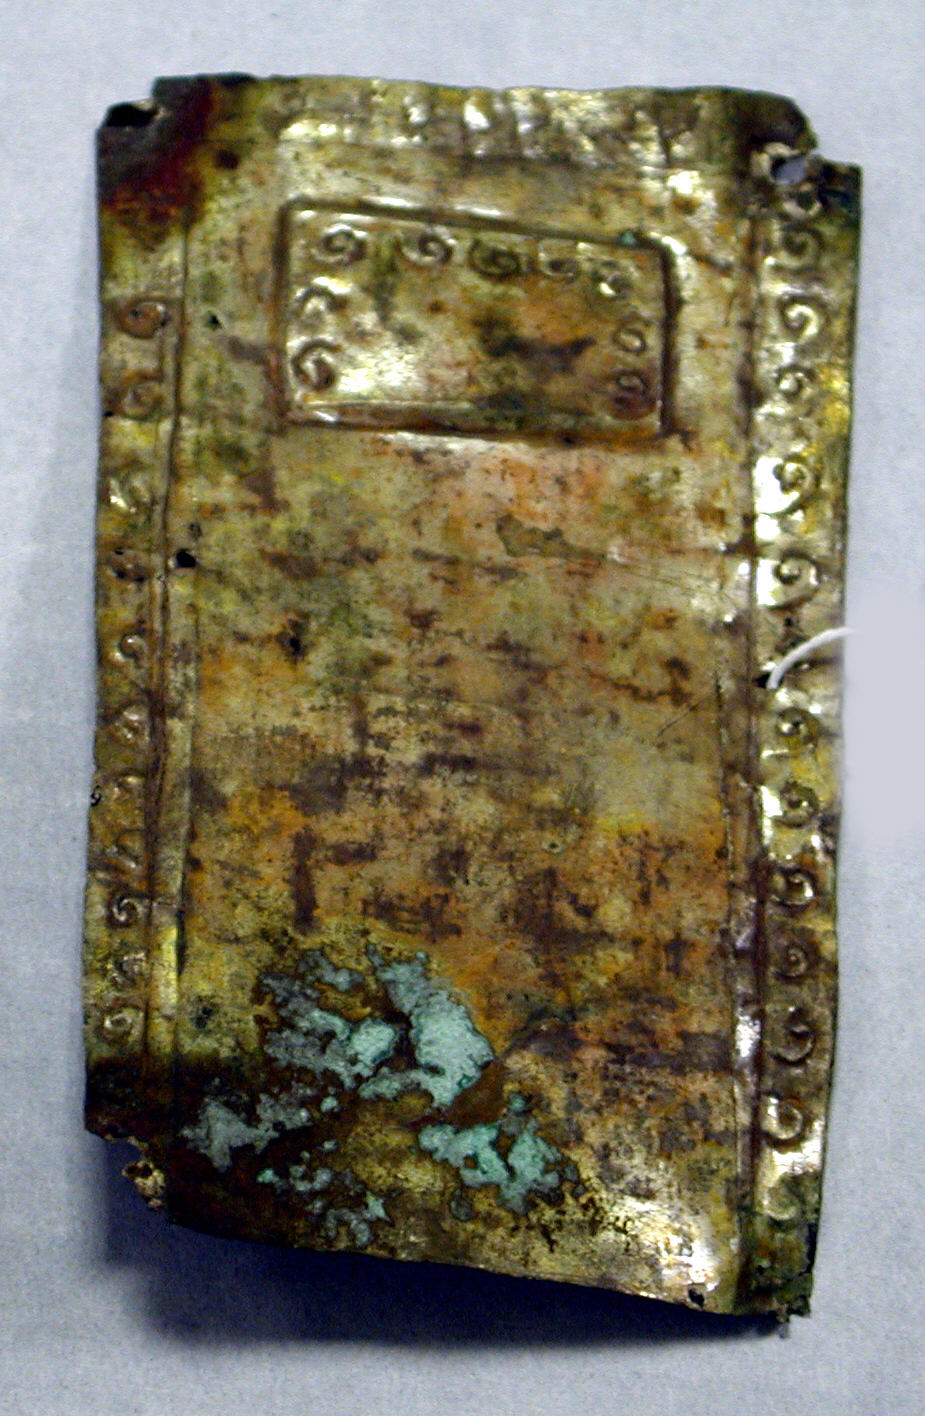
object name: ornament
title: Hammered Silver Ornament Plaque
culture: chancay or chimú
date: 1001-1500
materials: gilt, silver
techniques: hammering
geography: peru